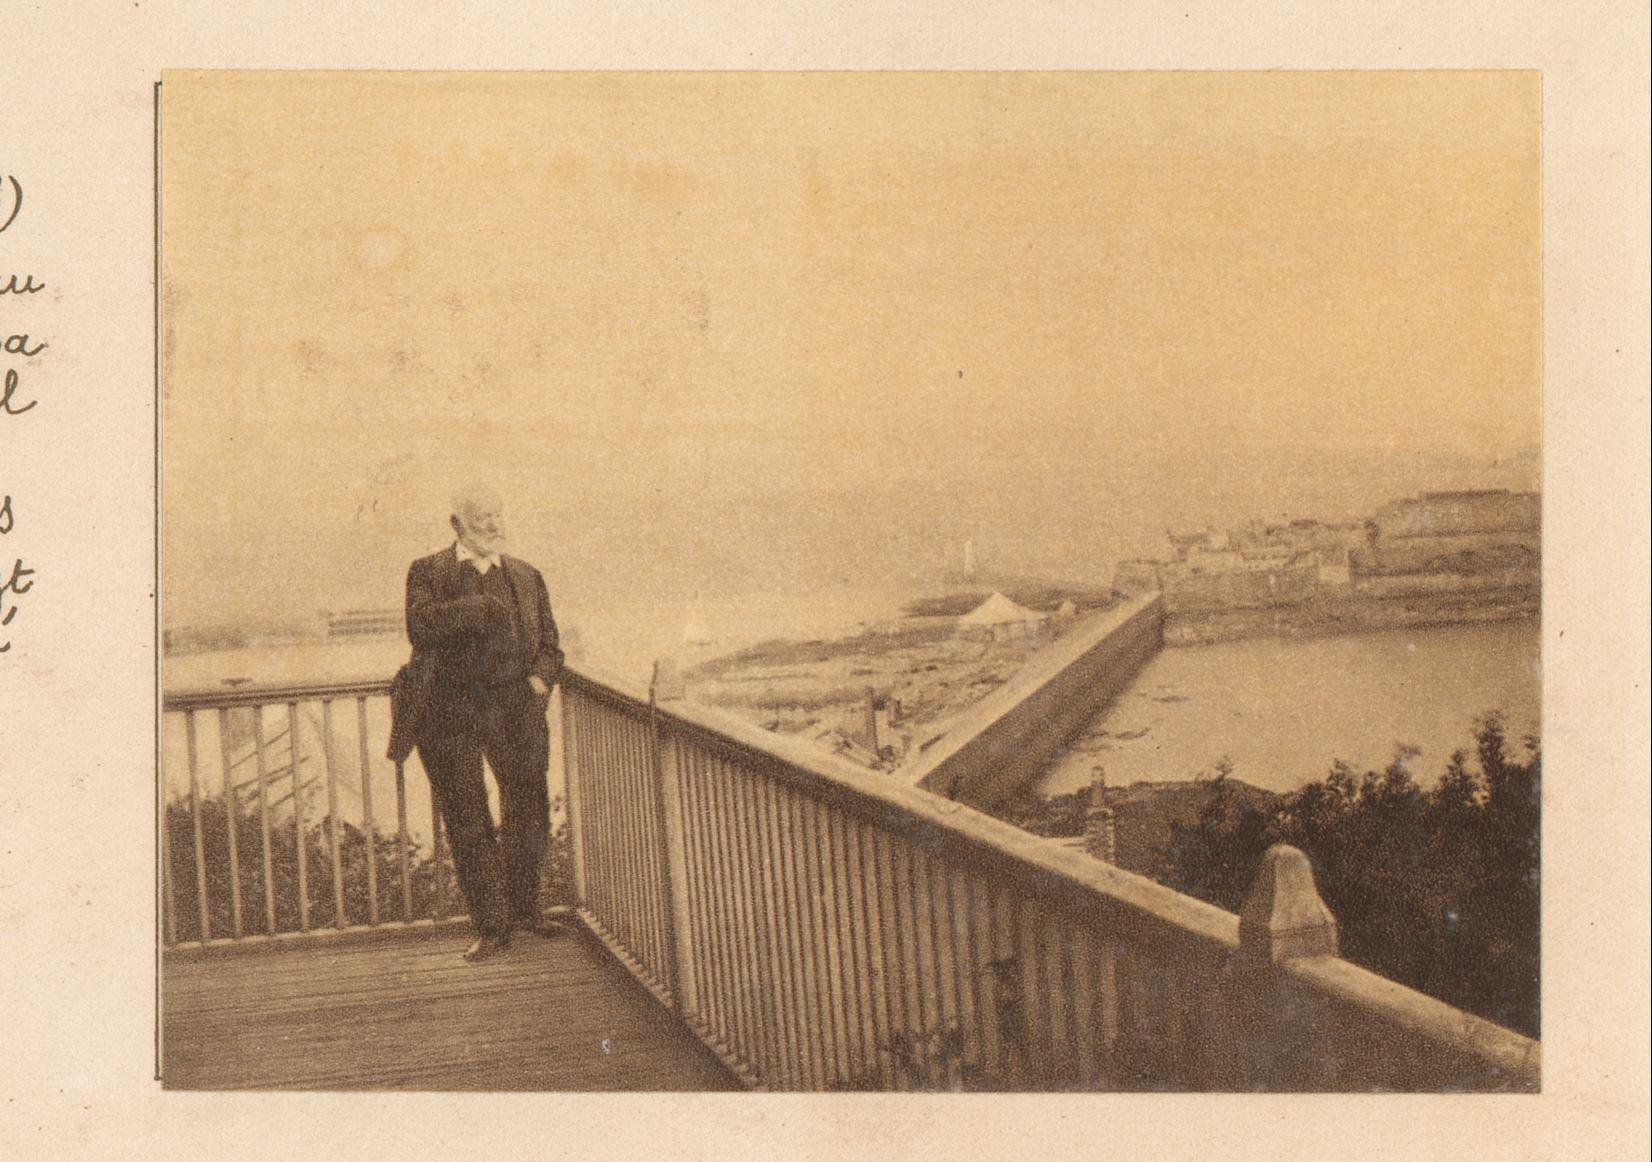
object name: album leaf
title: Victor Hugo op een balkon in Guernsey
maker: Anonymous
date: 1868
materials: paper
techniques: rotogravure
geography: guernsey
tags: paris, victor hugo, writer, poet, author